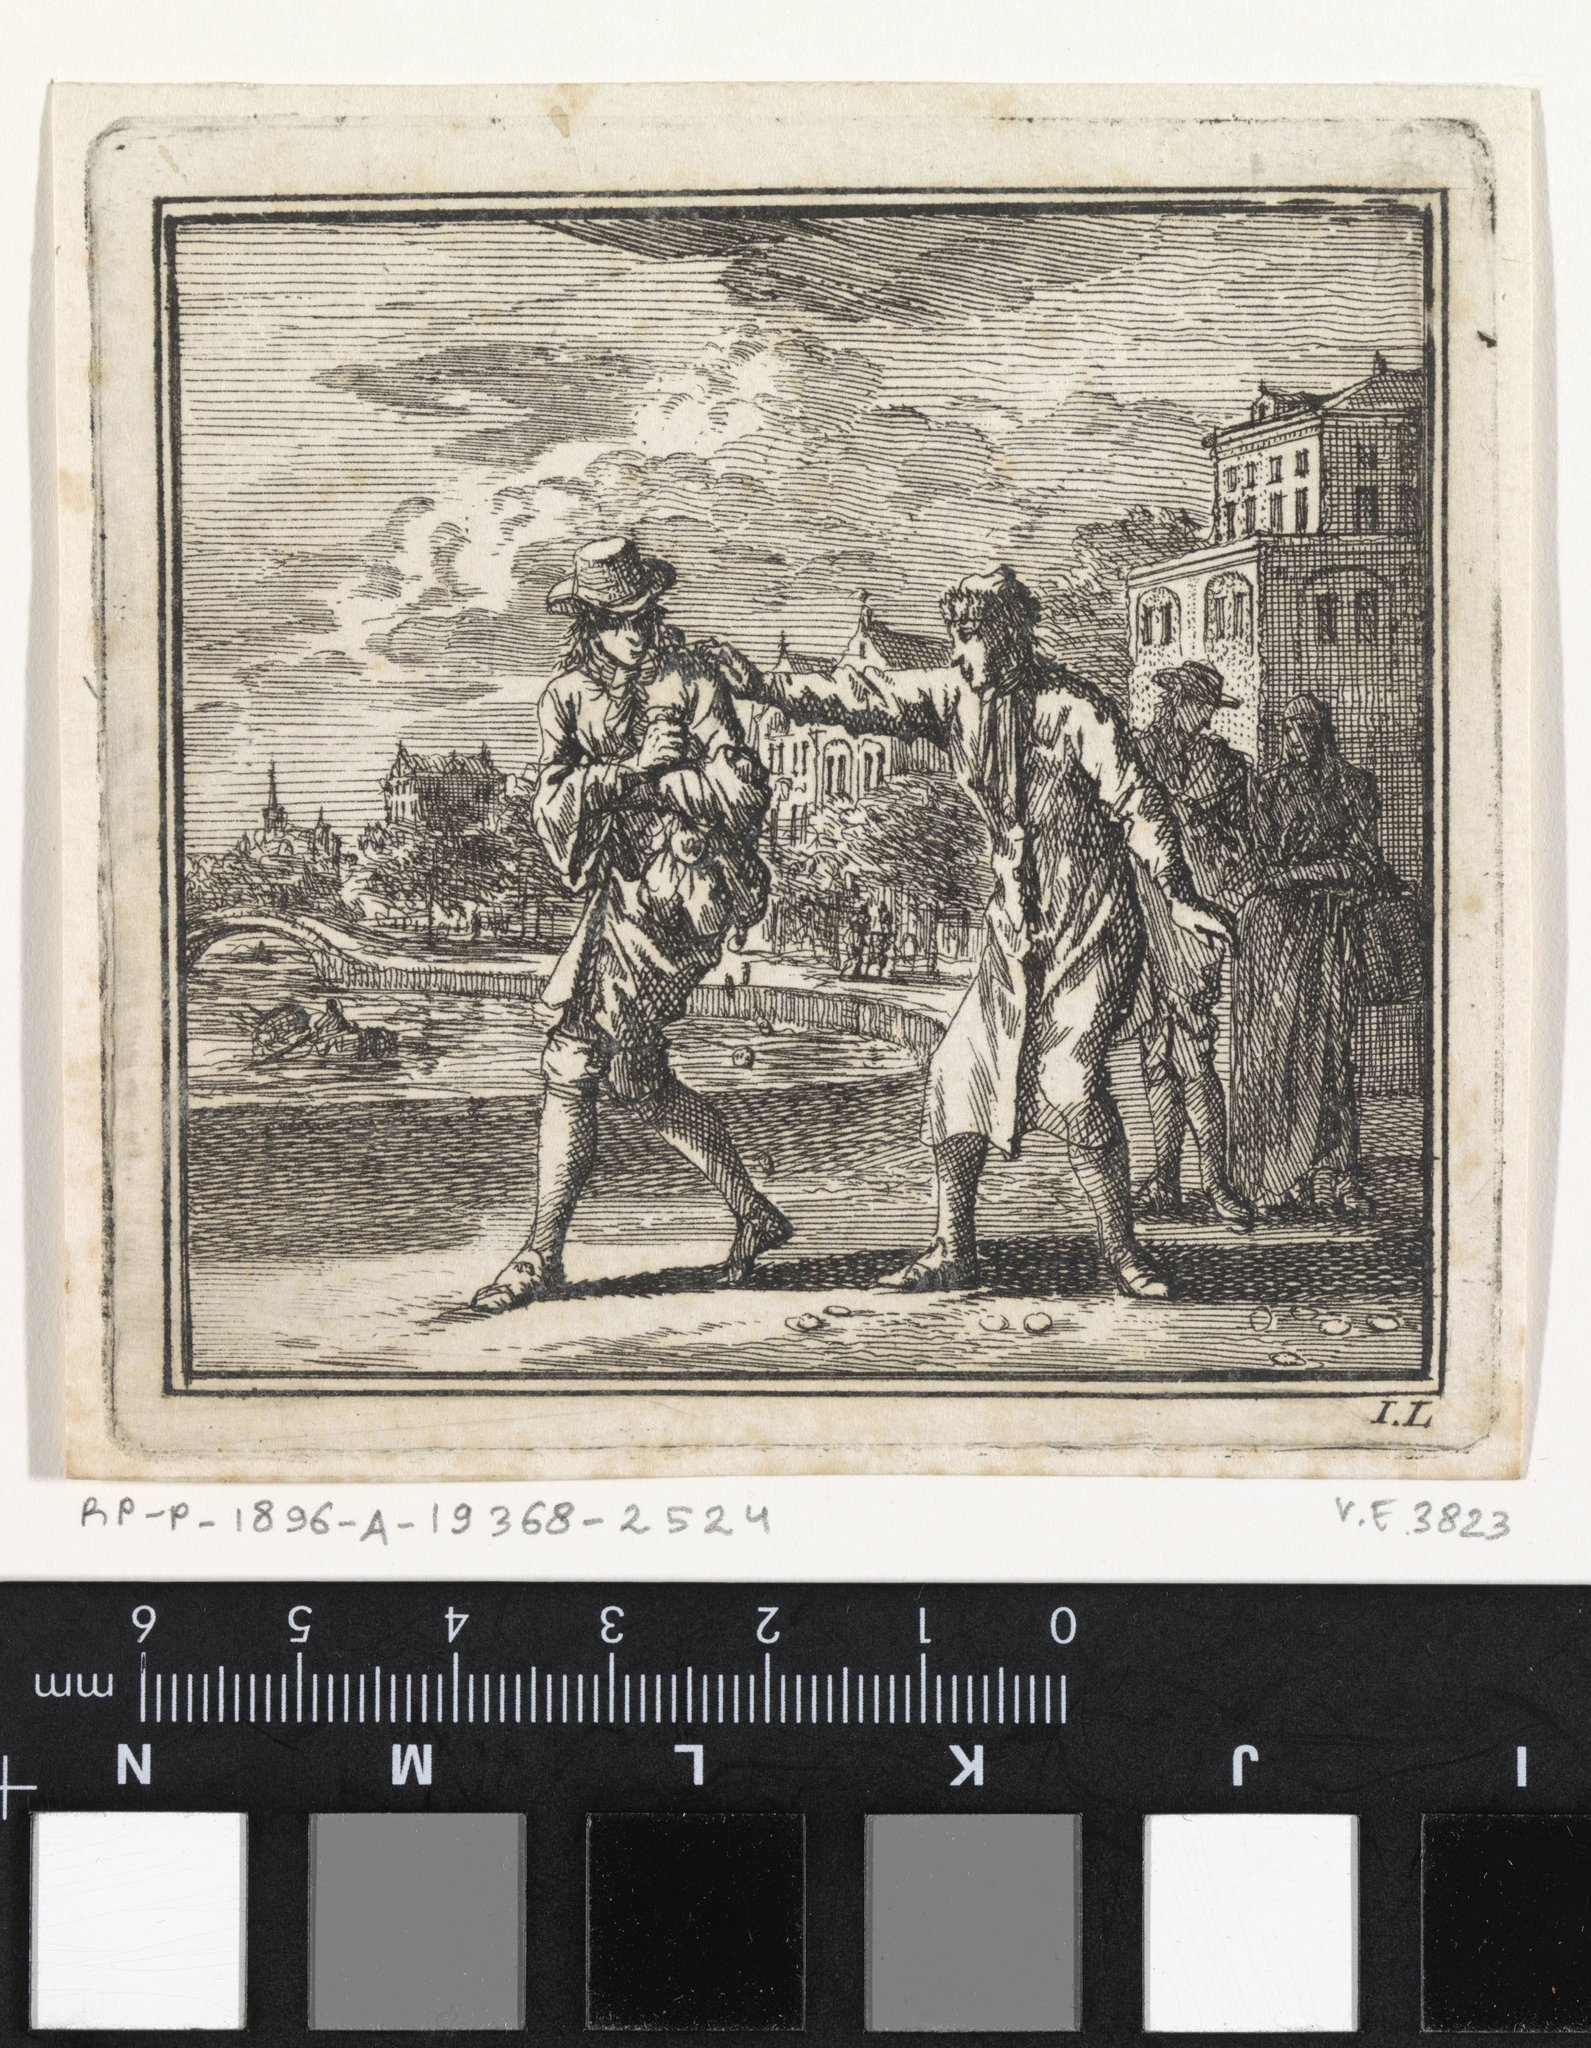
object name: print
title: Man wordt gewaarschuwd dat hij muntstukken verliest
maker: jan luyken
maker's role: draughtsman, print maker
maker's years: 1649-1712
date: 1710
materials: paper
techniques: etching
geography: amsterdam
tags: attention, concentration (+ situation or event (especially in genre-painting) with symbolical connotation), purse, money-bag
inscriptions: collector's mark: Lugt 2228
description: Illustratie uit: Luyken, Jan. De onwaardige wereld, vertoond in vyftig zinnebeelden, met godlyke spreuken en stichtelyke verzen. Amsterdam: Pieter Arentsz. II (wed.) en Cornelis van der Sys, 1710, p. 108.